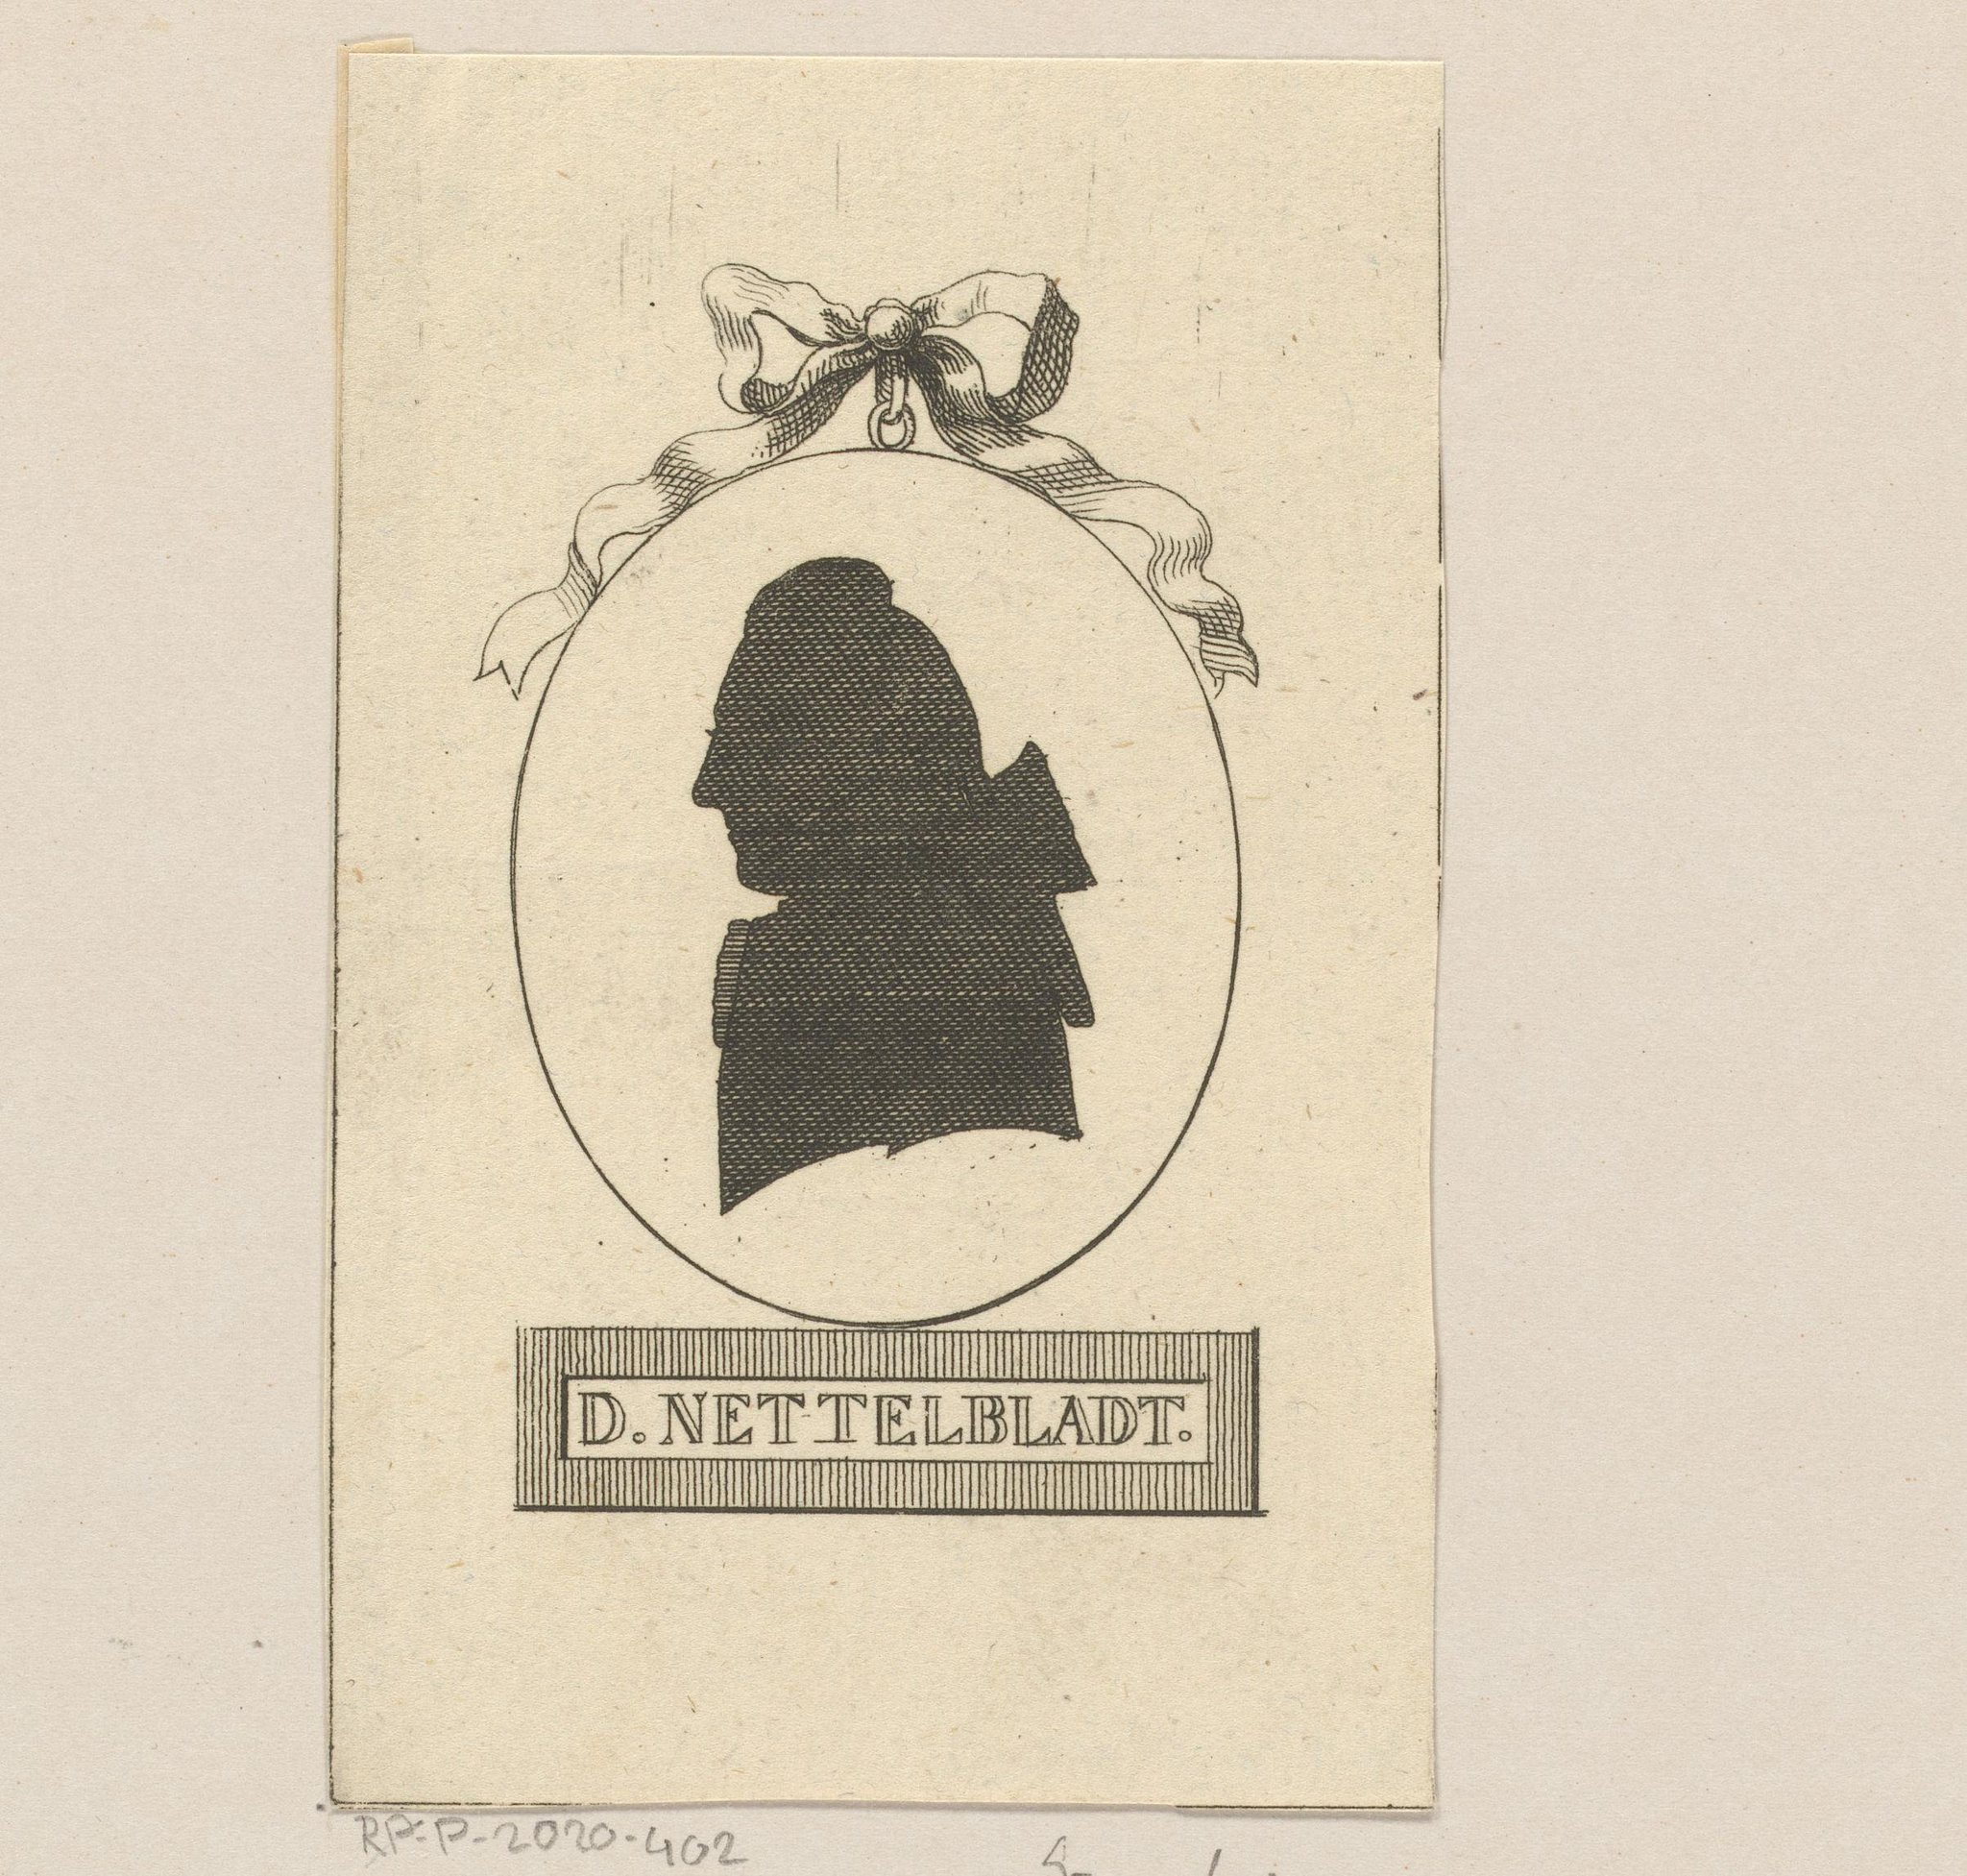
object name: print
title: D. Nettelbladt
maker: Anonymous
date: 1750-1799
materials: paper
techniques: etching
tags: halle, historical persons